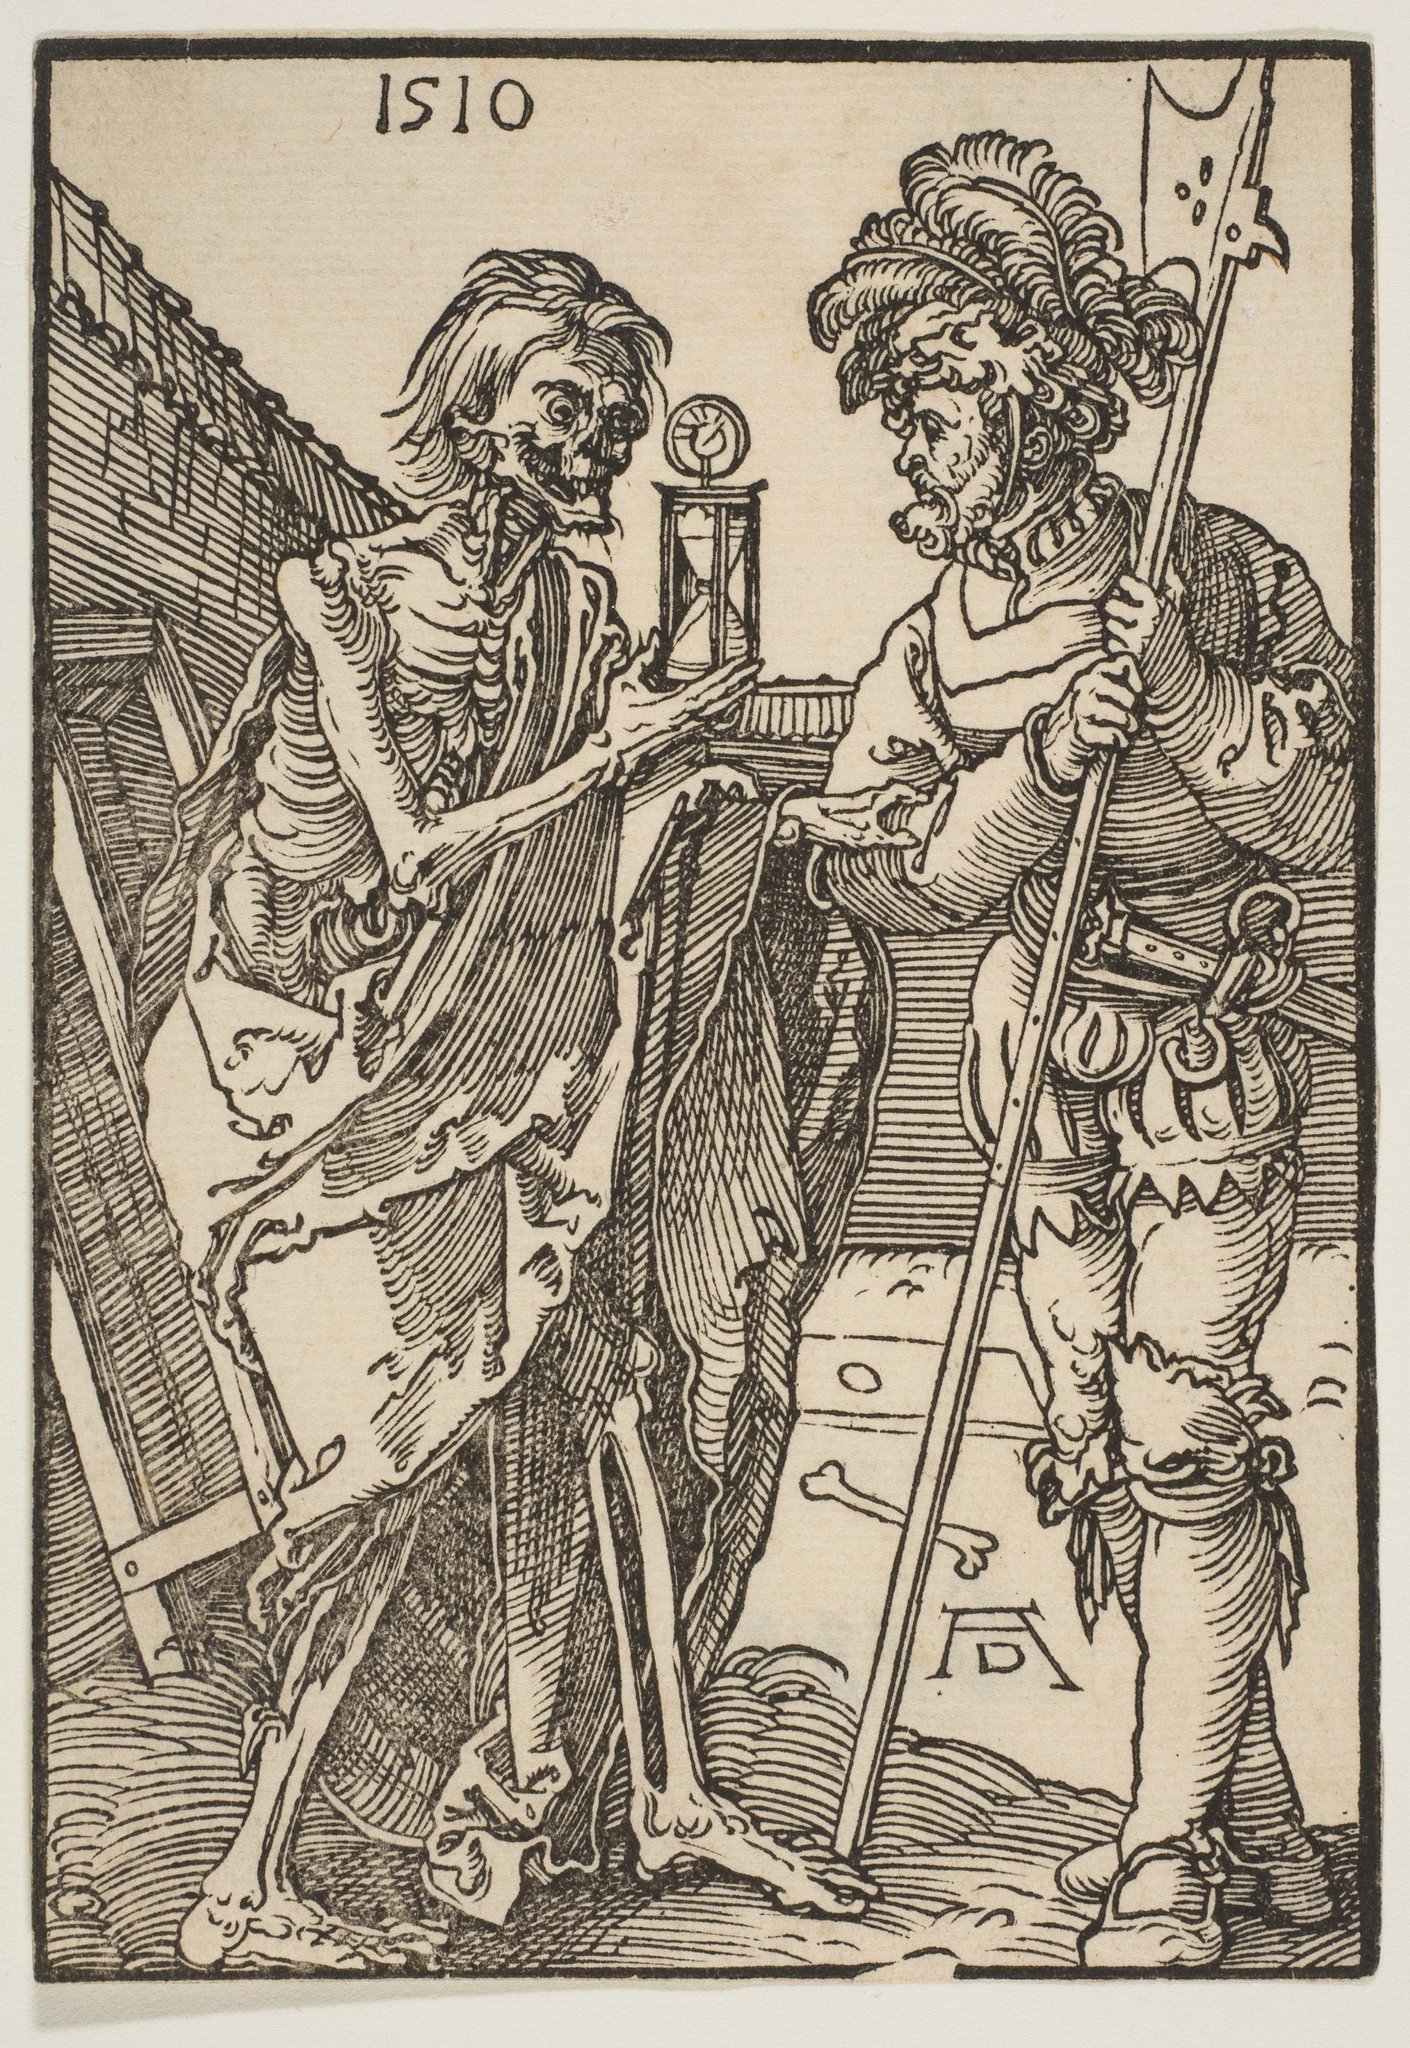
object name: print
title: Death and the Lansquenet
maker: albrecht dürer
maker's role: artist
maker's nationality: german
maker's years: 1471-1528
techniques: woodcut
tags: weapons,skeletons,men